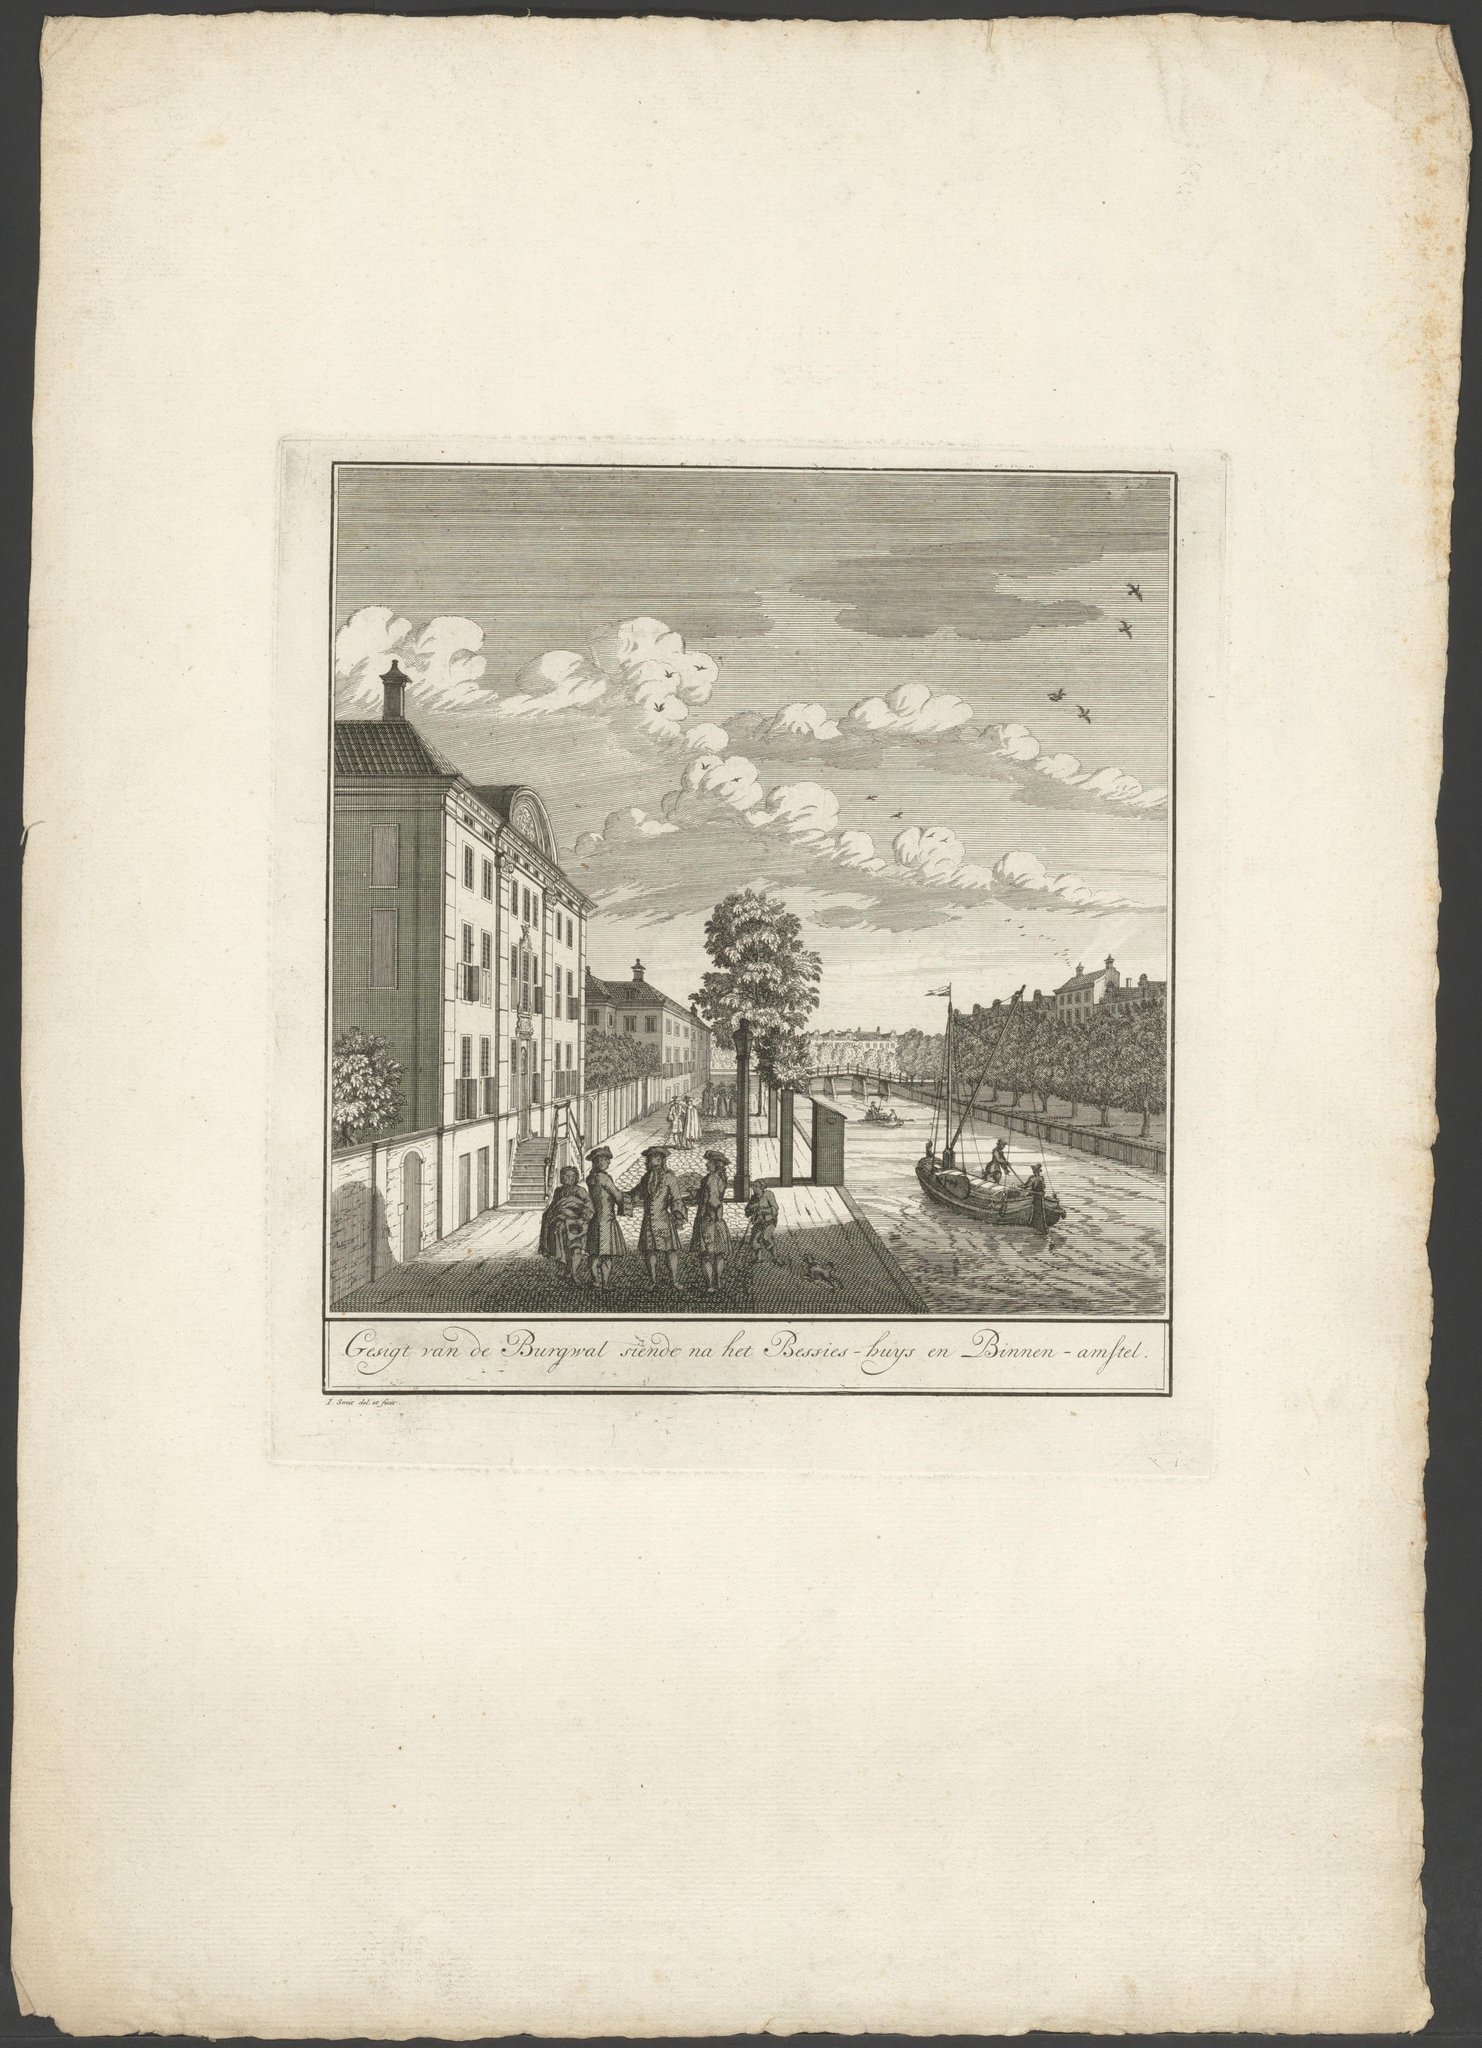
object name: print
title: Het Corvershof te Amsterdam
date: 1723-1748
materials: paper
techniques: engraving, etching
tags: alms-house (dutch: 'hofje'), bridge in city across river, canal, etc. (+ city(-scape) with figures, staffage), public welfare, canals, waters (in city), old-people's home, street (+ city(-scape) with figures, staffage)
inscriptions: collector's mark, collector's mark: ‘ARMWEZEN EN LIEFDADIGHEID’, collector's mark: Lugt 1641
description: Gezicht op het Corvershof (links) aan de Nieuwe Herengracht te Amsterdam. Gezien richting de Binnen-Amstel, met links op de achtergrond een stuk van het Diaconie Oude Vrouwen- en Mannenhuis. Op straat staan groepjes pratende mensen. Onderdeel van een serie prenten van het in 1723 in gebruik genomen Corvershof, bestemd voor oudere echtparen van Nederduits Gereformeerde (later Hervormde) huize. Onderwerpsrubrieken binnen de Atlas Zeden en Gewoonten: Armwezen en Liefdadigheid.